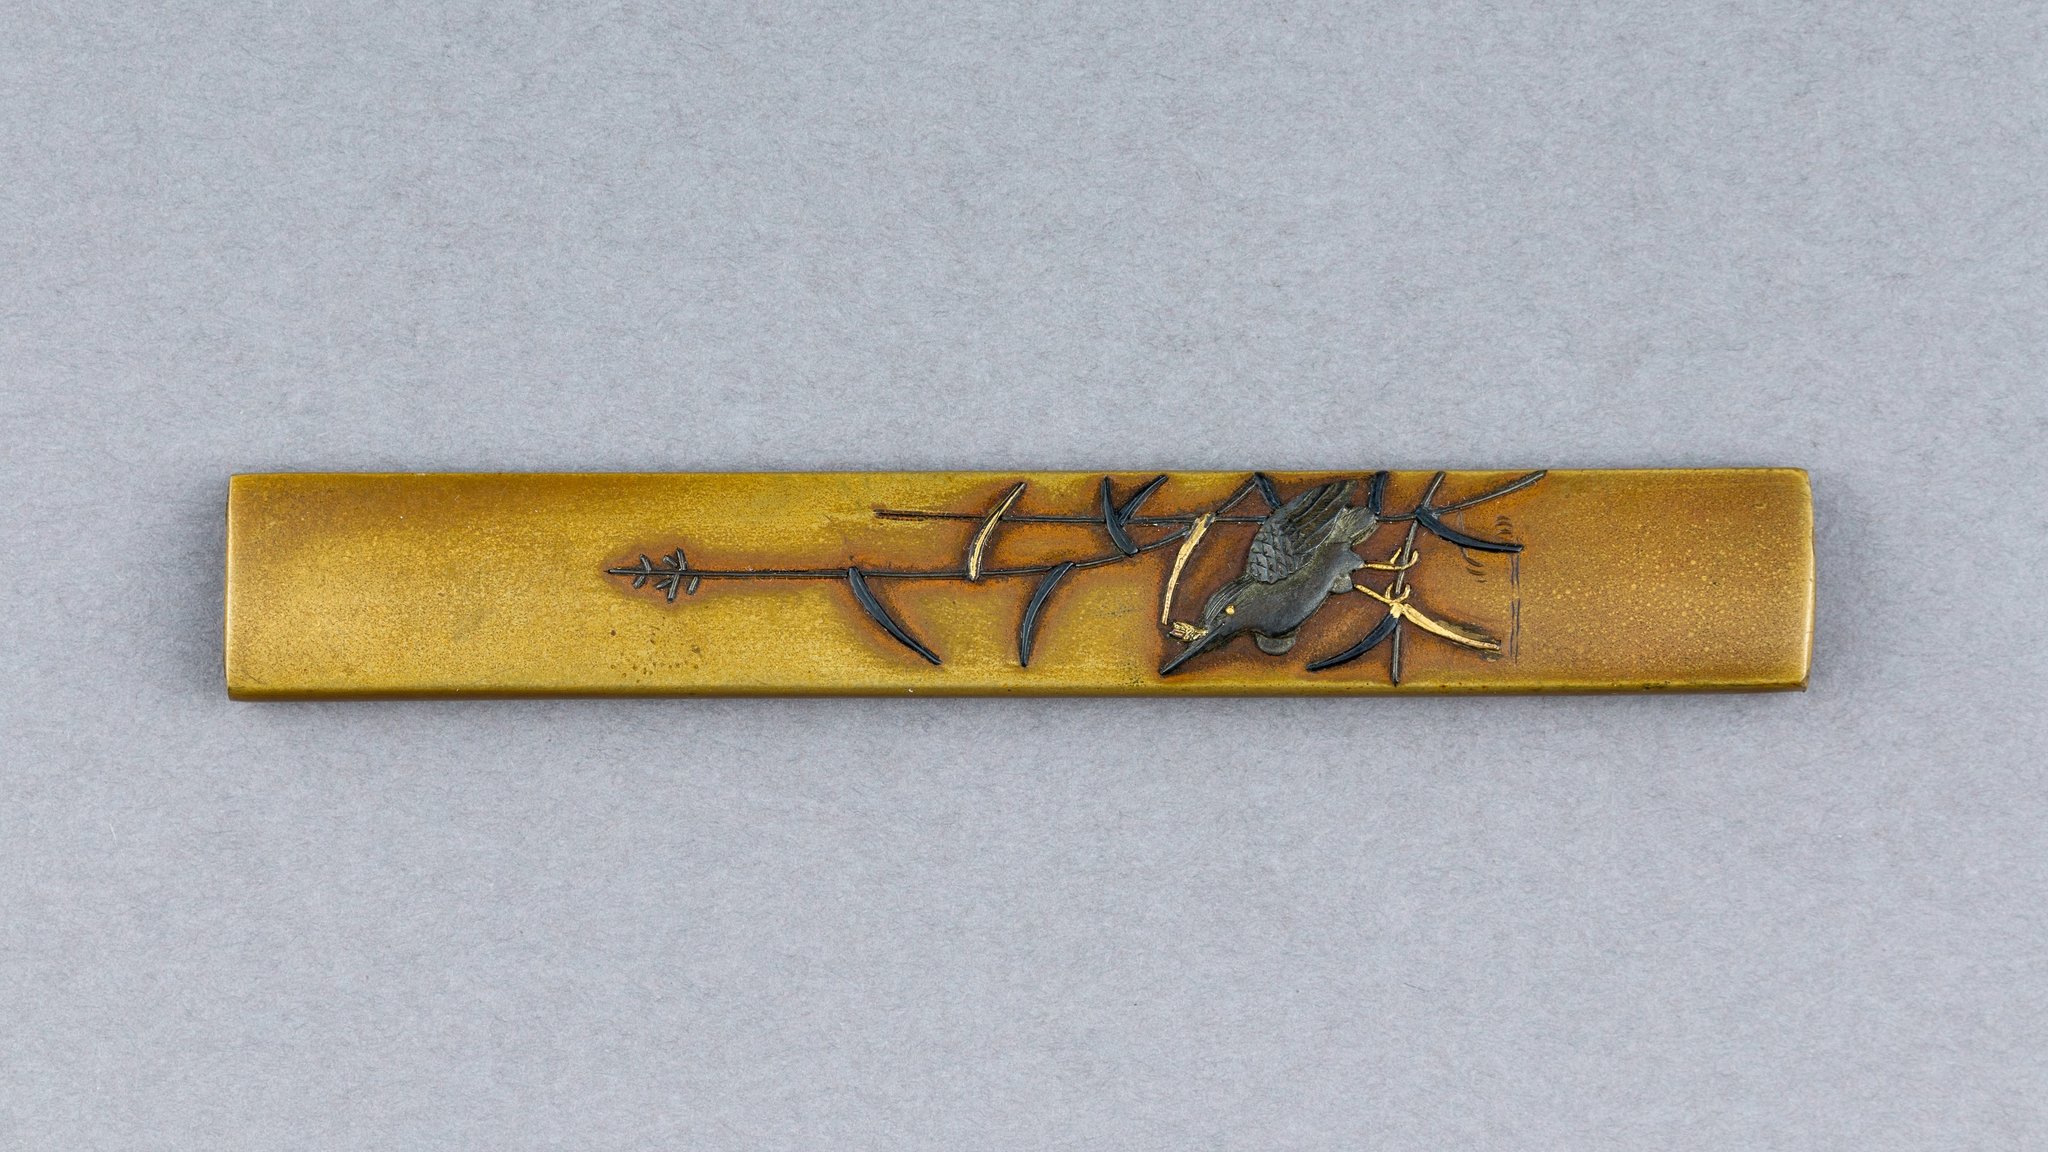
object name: knife handle kozuka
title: Knife Handle (Kozuka)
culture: japanese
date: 1615-1868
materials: gold alloy, silver alloy, gold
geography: japan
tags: birds